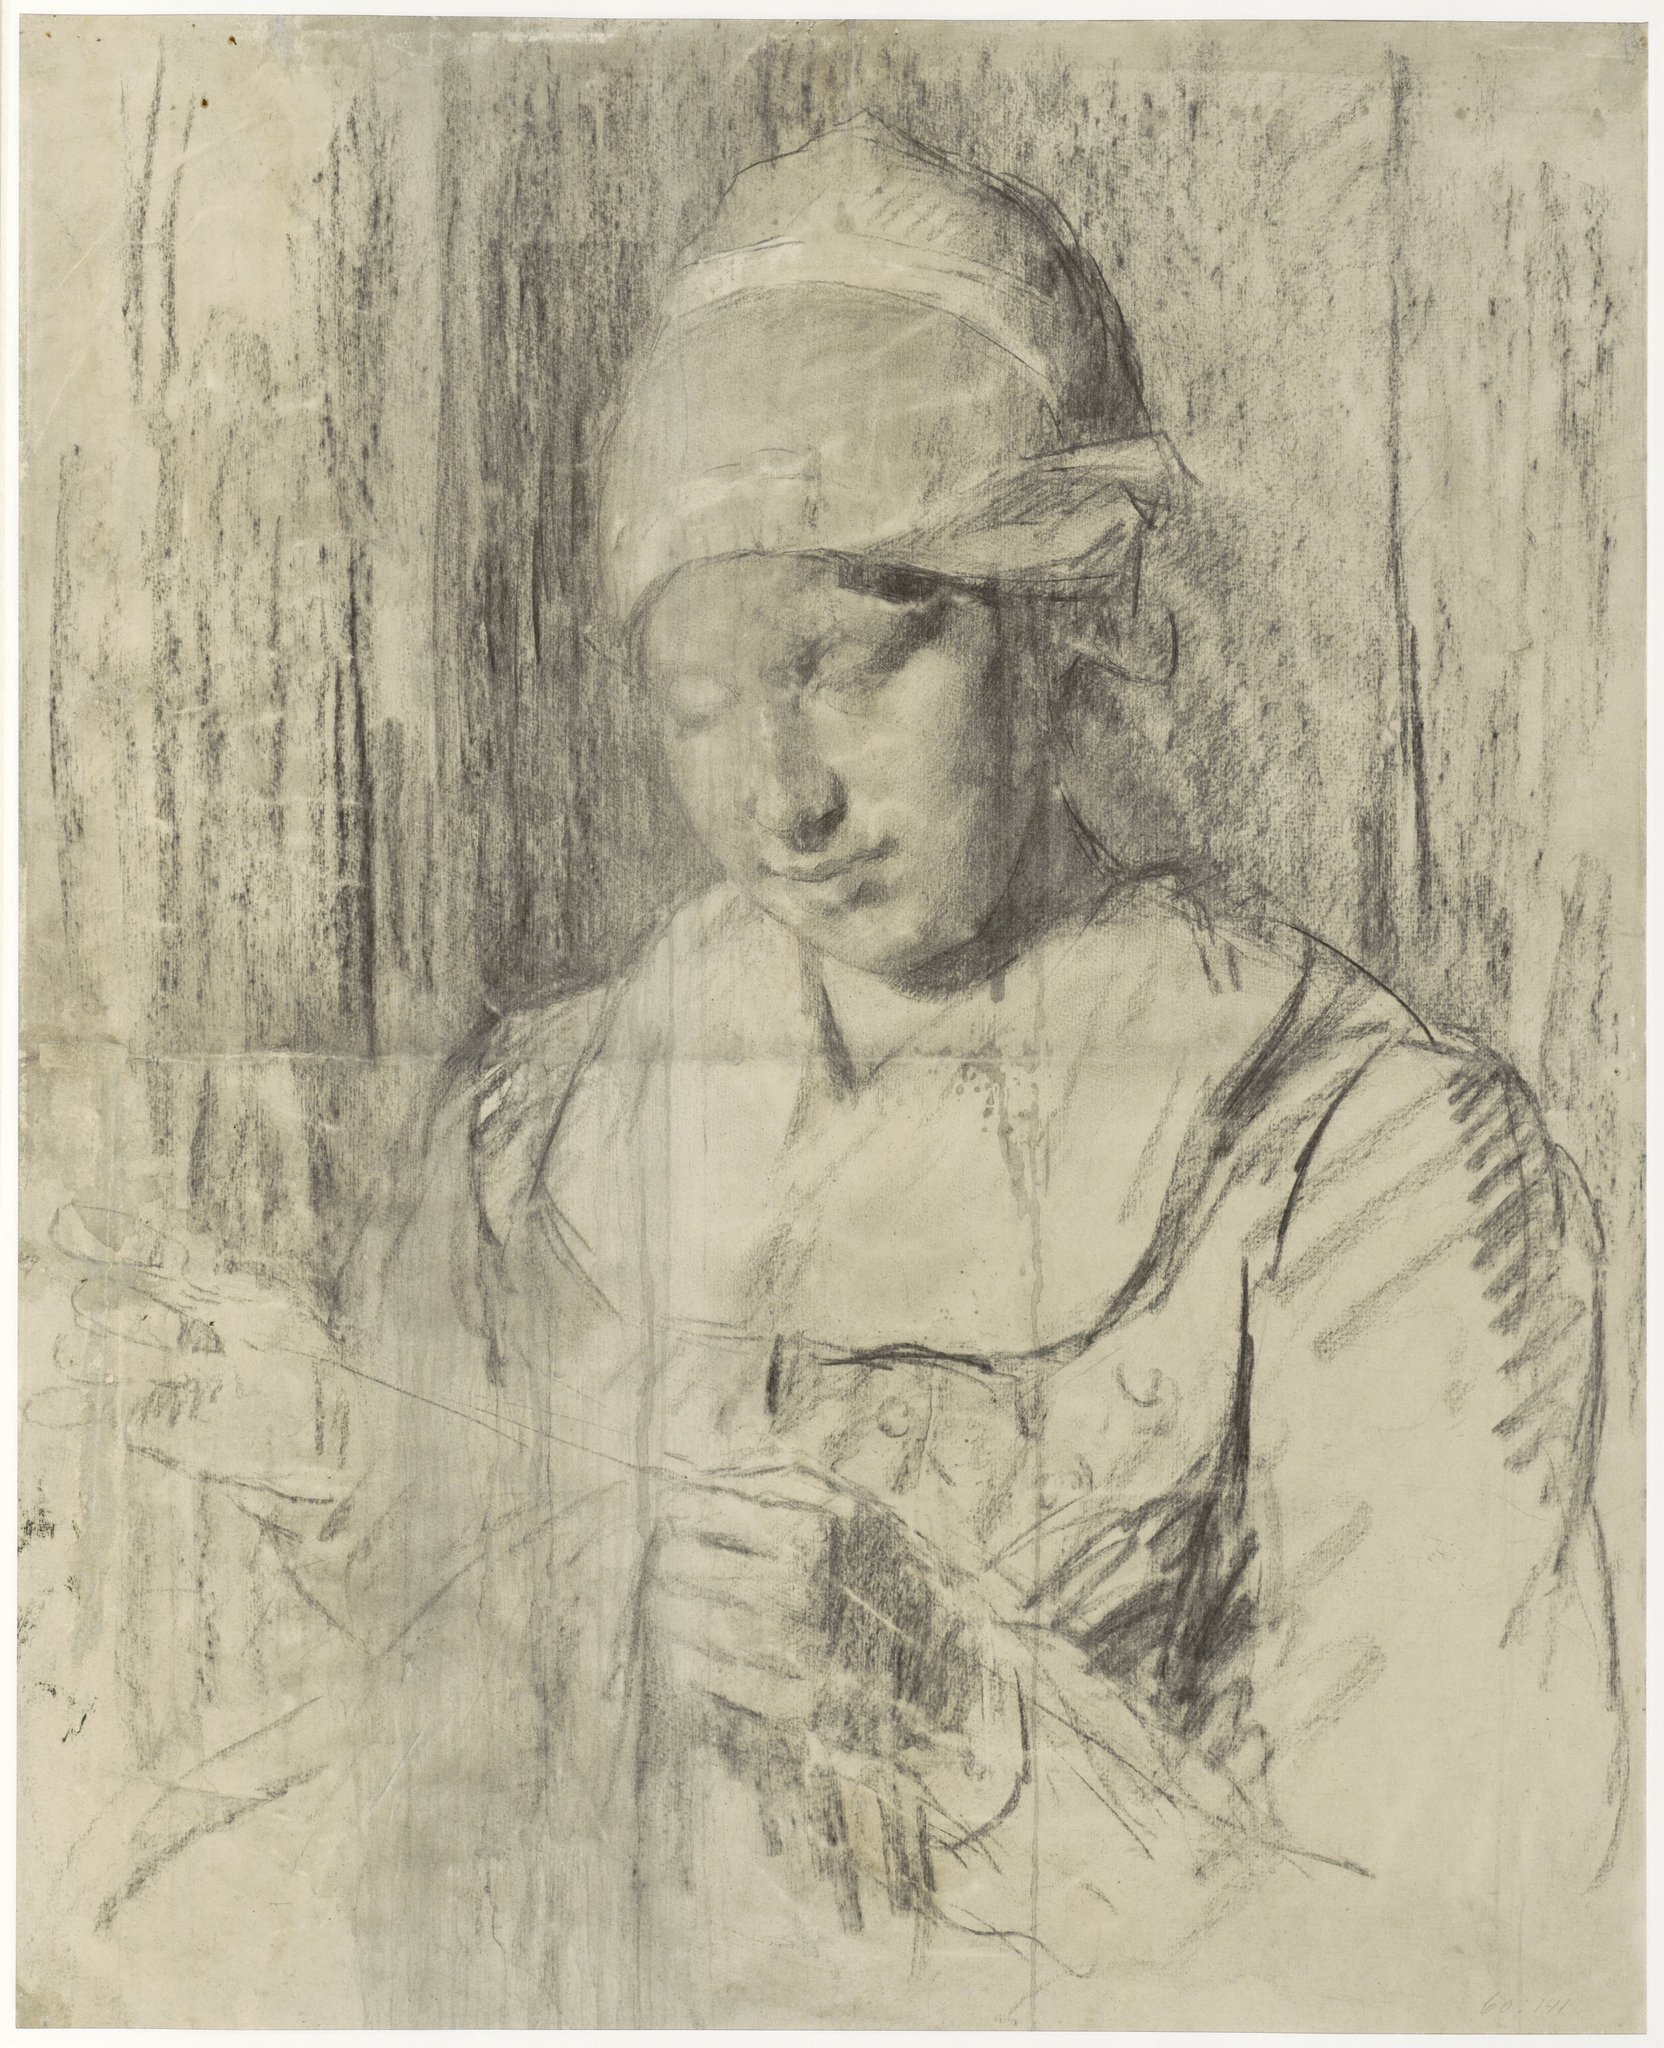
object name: drawing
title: Studie van een weesmeisje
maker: thérèse schwartze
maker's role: draughtsman, painter, print maker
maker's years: 1851-1918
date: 1861-1918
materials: charcoal, paper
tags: anonymous historical person portrayed alone, orphans, sewing